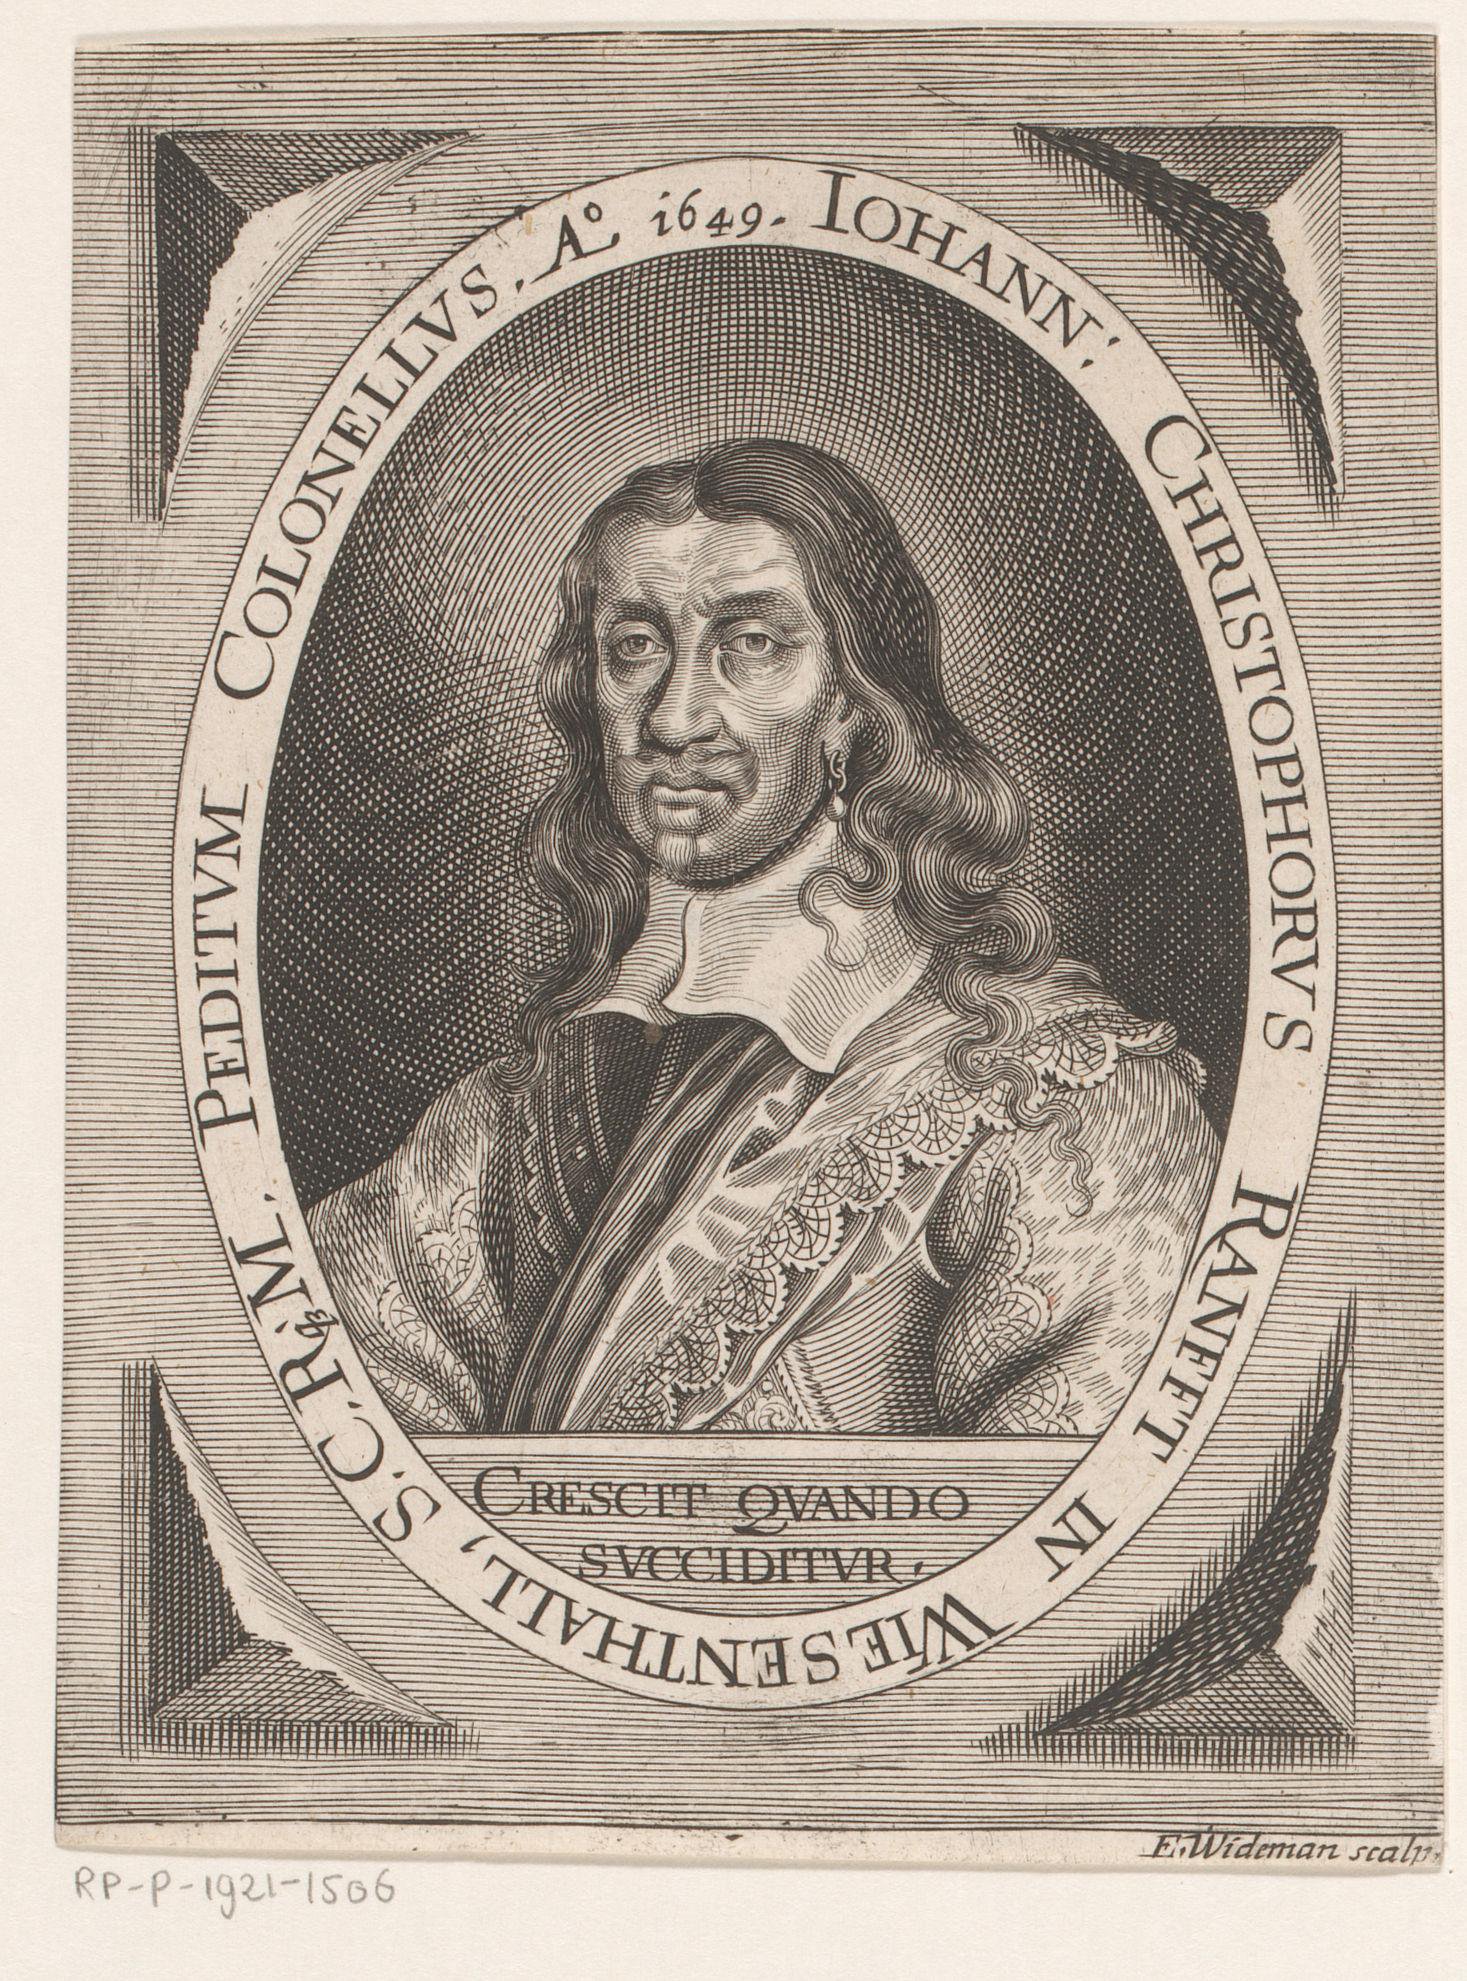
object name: print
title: Portret van Johann Christoph Ranfft von Wiesenthal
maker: elias widemann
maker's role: print maker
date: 1649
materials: paper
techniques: engraving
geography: vienna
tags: historical persons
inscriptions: collector's mark: Lugt 2233